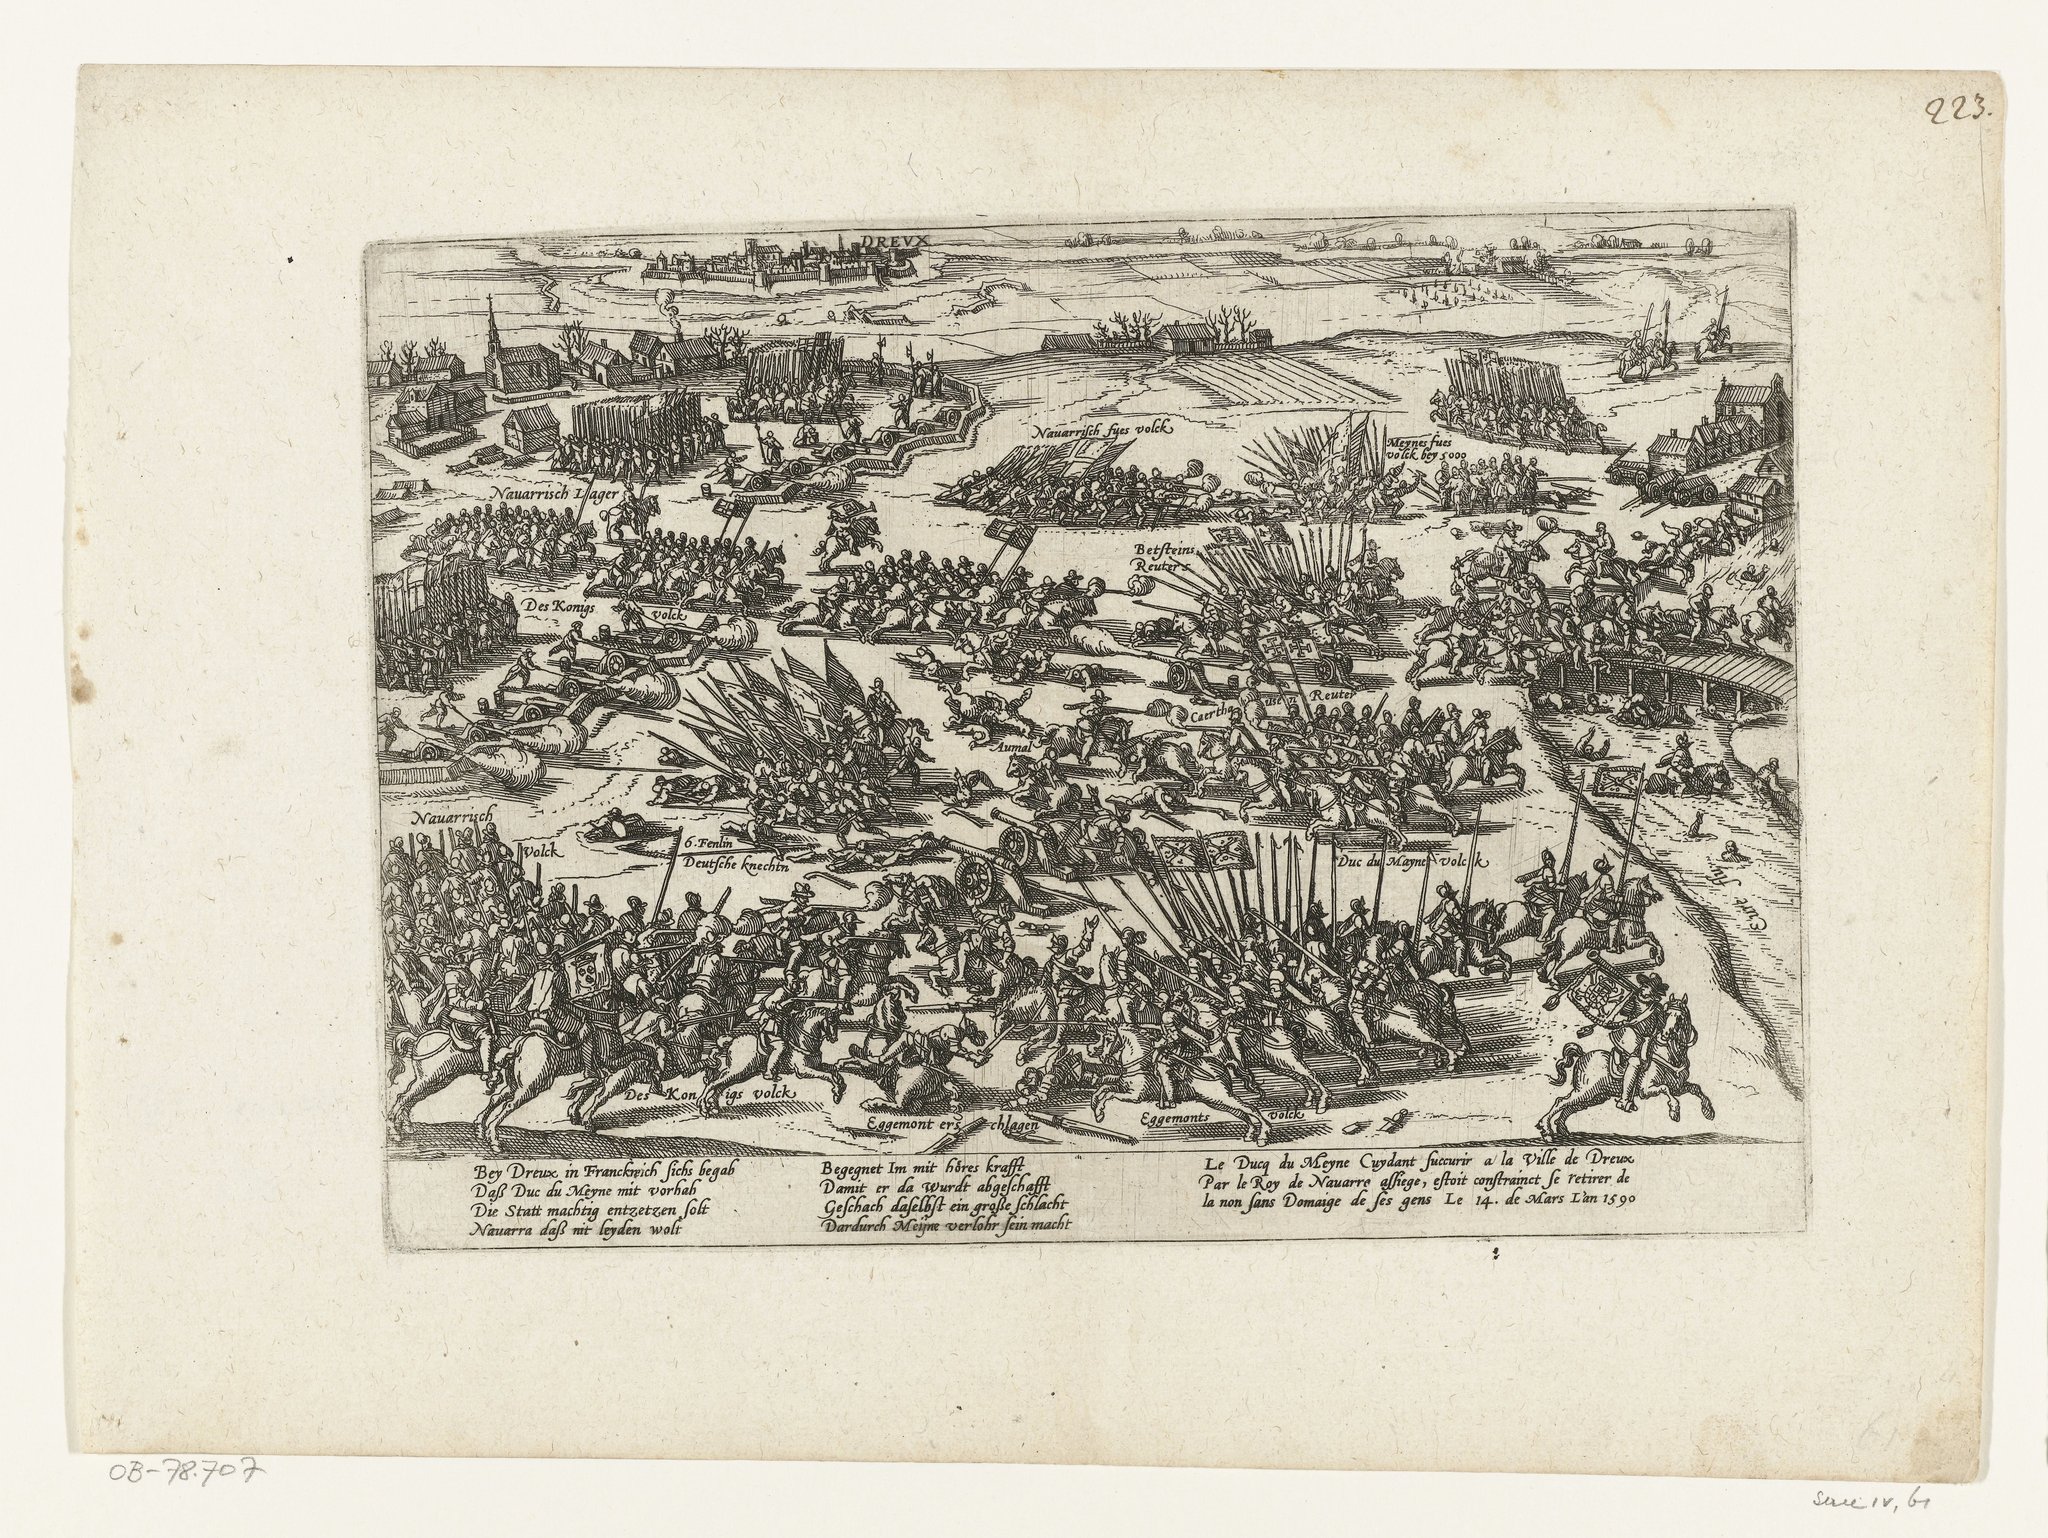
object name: print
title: Slag bij Ivry (Dreux), 1590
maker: frans hogenberg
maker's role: print maker, publisher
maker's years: 1538-1590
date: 1590-1592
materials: paper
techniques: etching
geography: cologne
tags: paris, hendrik iv (koning van frankrijk en navarra), battle, fighting in general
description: Gezicht op de veldslag bij Ivry (Dreux), 14 maart 1590. In de verte de ommuurde stad. Met onderschrift van 8 regels in het Duits en 3 regels in het Frans. Ongenummerd. Blad afkomstig uit een album dat uit elkaar is gehaald. Rechtsboven genummerd (in pen): 223.